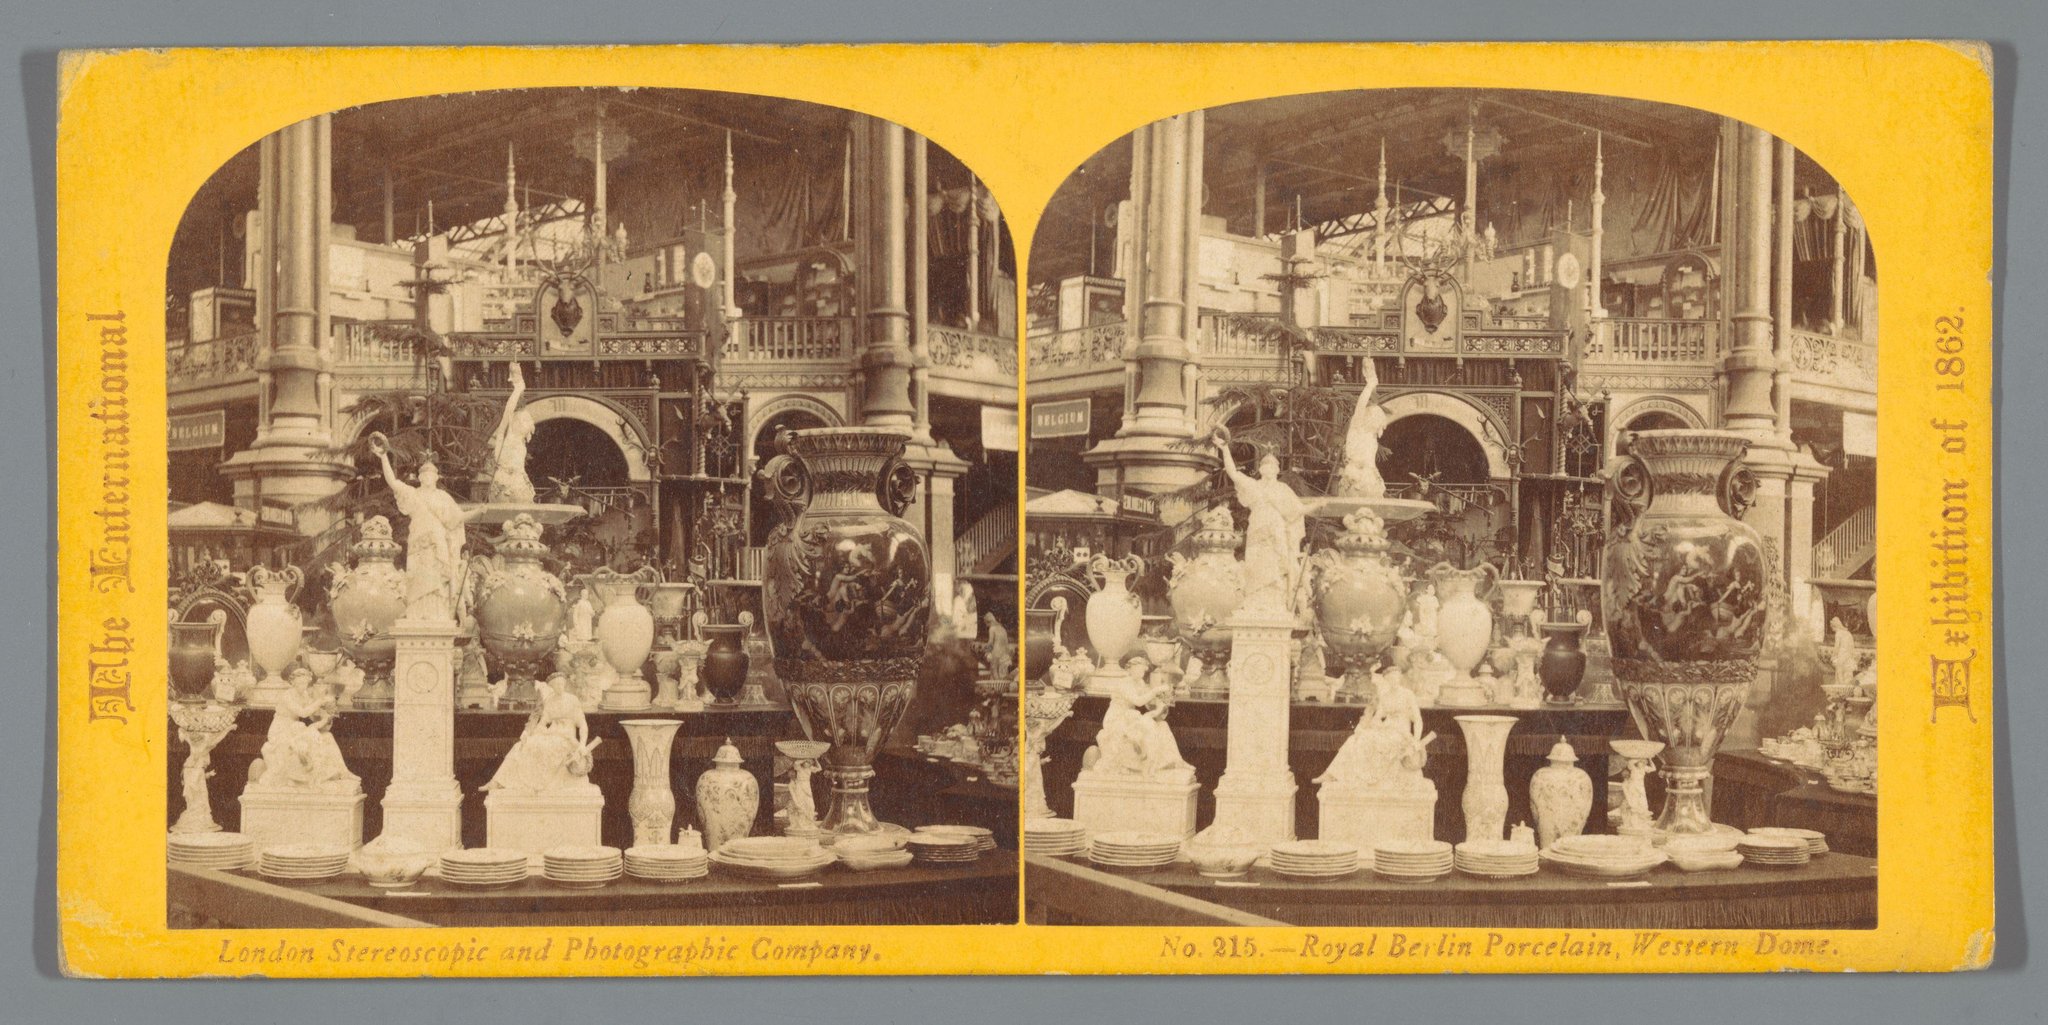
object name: stereograph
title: Berlijns porselein op de Wereldtentoonstelling van 1862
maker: william england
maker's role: fotograaf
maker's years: 1816-1896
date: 1862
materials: cardboard, paper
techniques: albumen print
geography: london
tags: world fair, world exhibition, container of ceramics: jar, jug, pot, vase, london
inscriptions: number: ‘No. 215.’